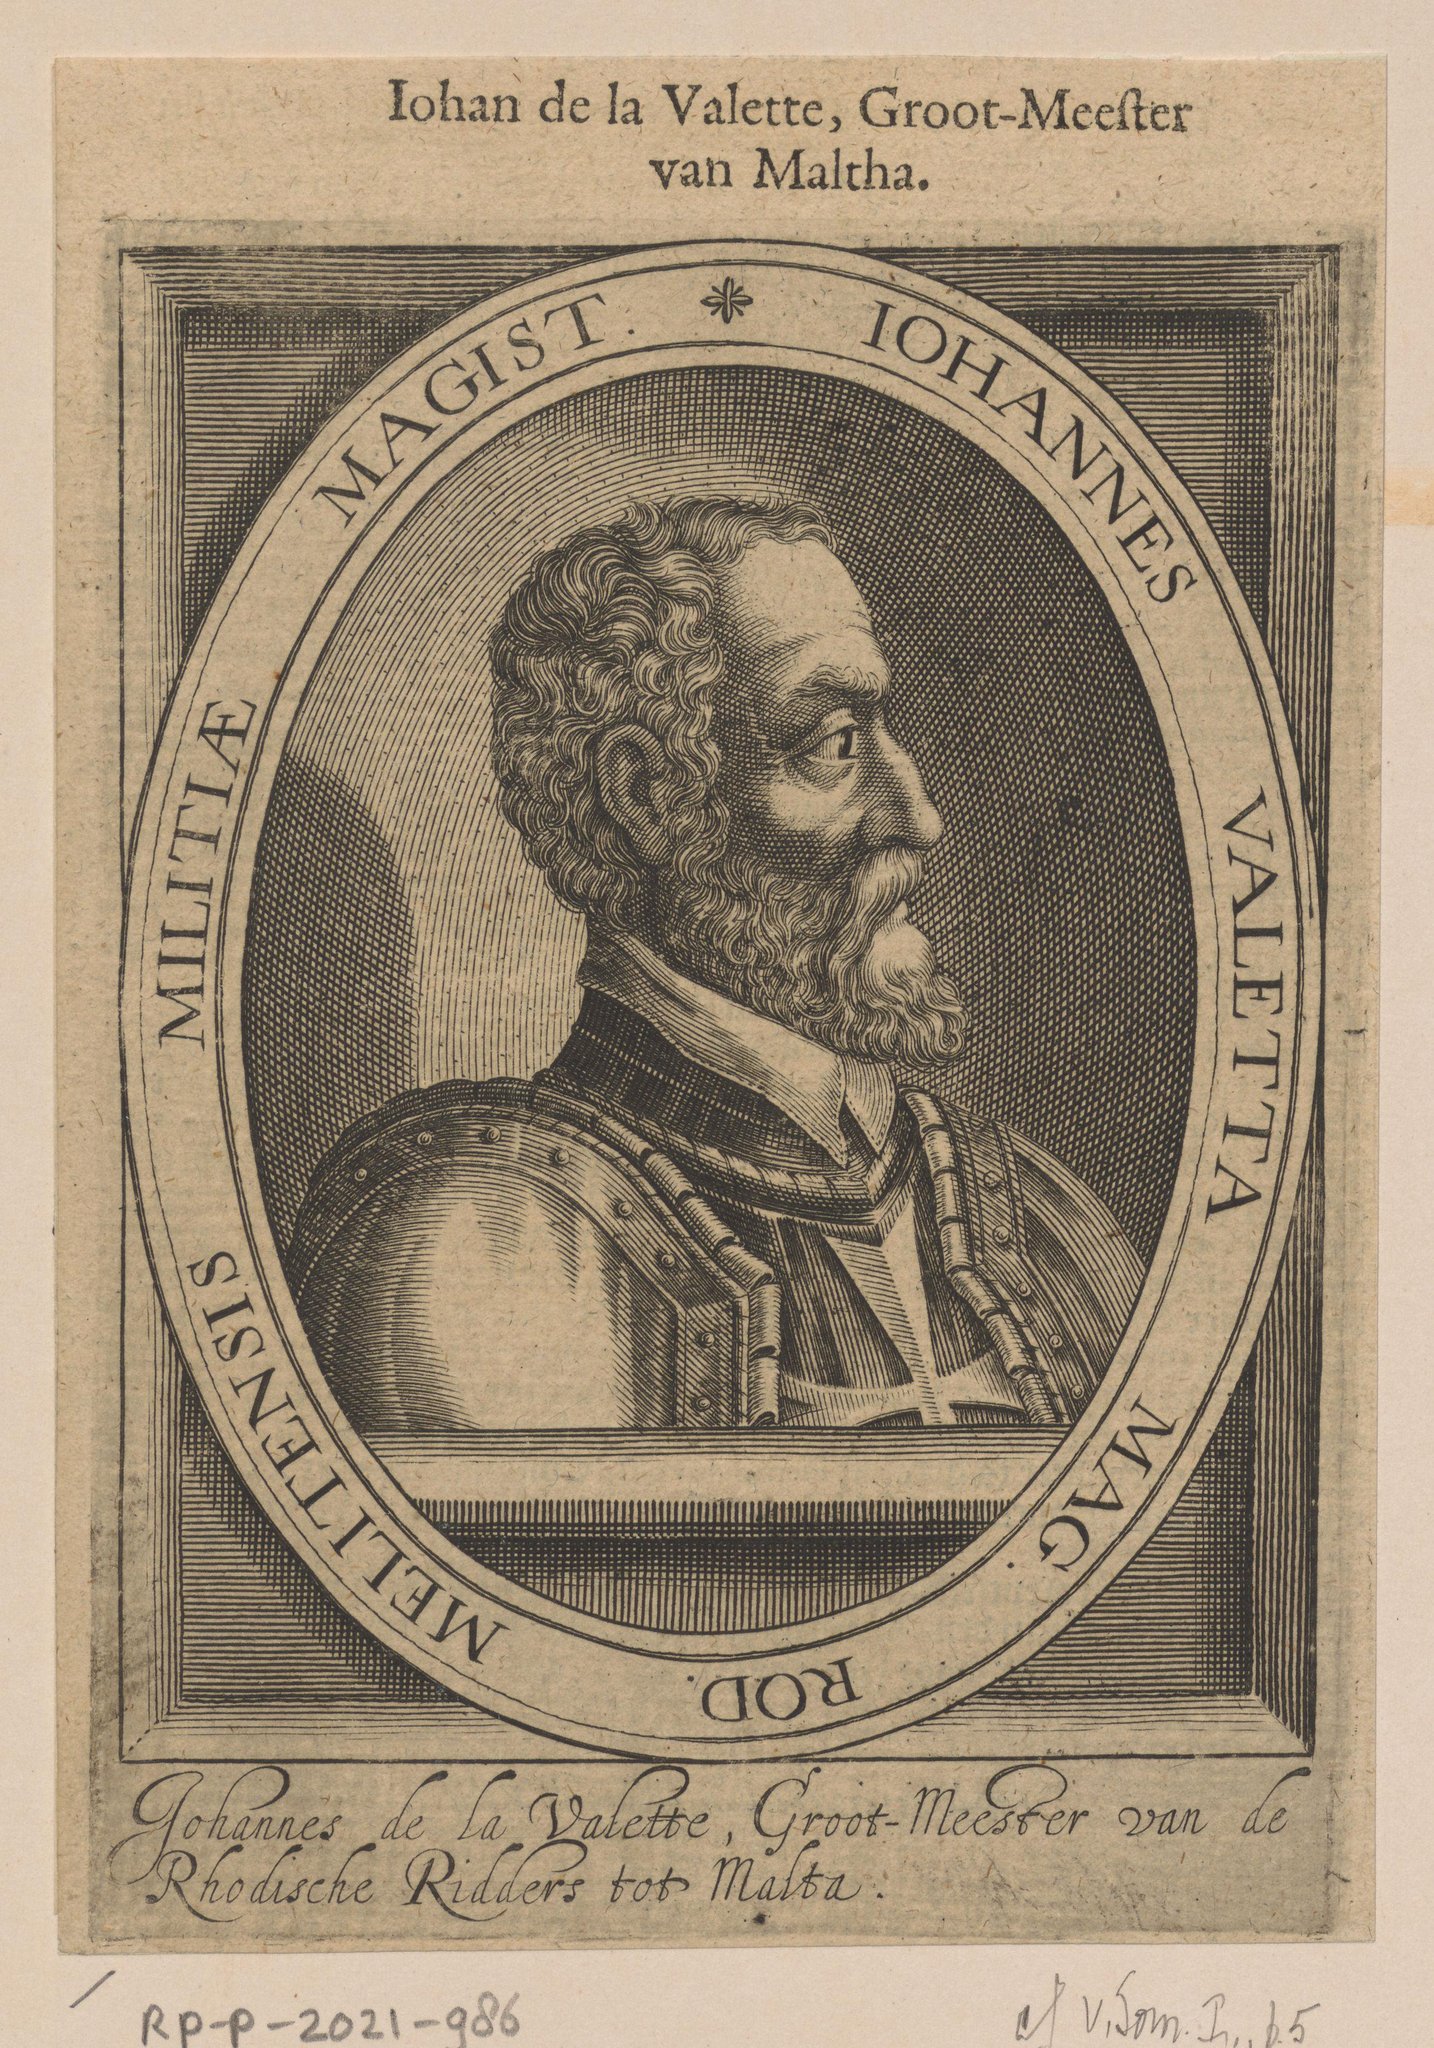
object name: book illustration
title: Portret van Jean Parisot de La Valette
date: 1617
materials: paper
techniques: engraving, letterpress printing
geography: delft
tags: armour, historical persons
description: Prent uit: Tooneel der beroemder hertogen princen graven ende krygs-helden van christenrijck binnen deze drij laetste eeuwen. Delft: Nicolaes de Clerck, 1617, p. 356.